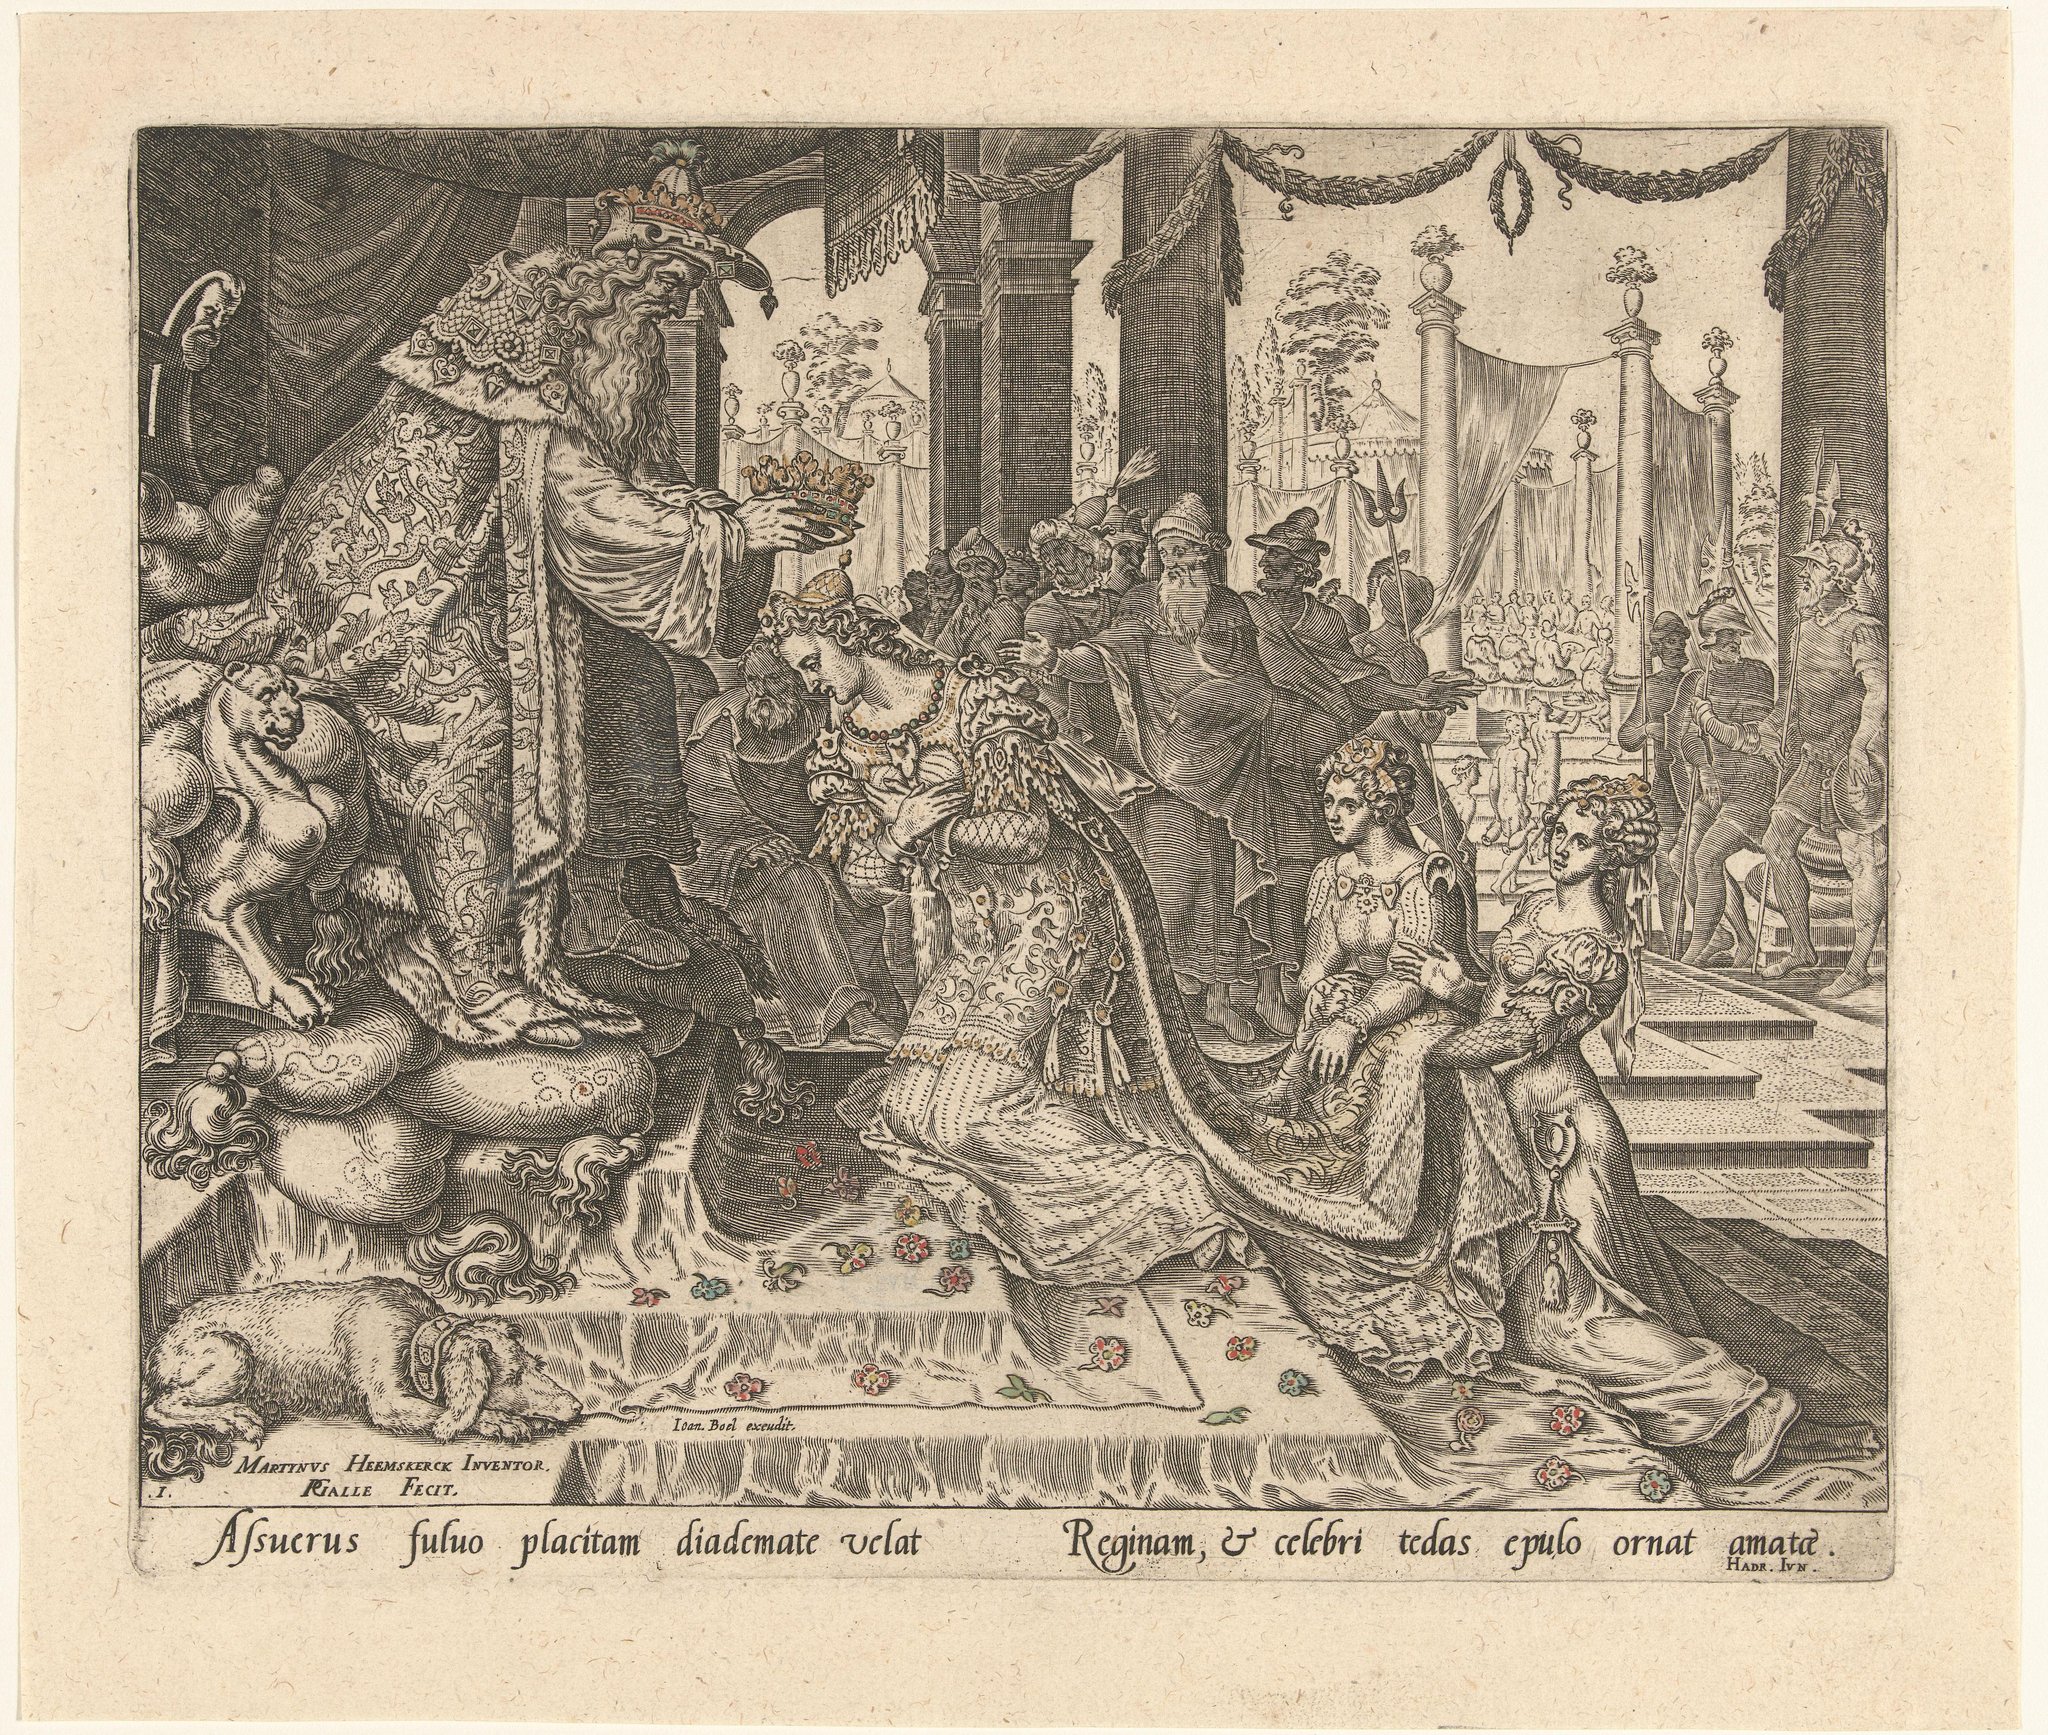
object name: print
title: Kroning van Ester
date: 1564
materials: paper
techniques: engraving, hand coloring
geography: antwerp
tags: crowning of esther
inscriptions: collector's mark: Lugt 2228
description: Ahasveros kroont Ester tot zijn koningin. Ester knielt voor zijn troon, twee hofdames houden de sleep van haar jurk.